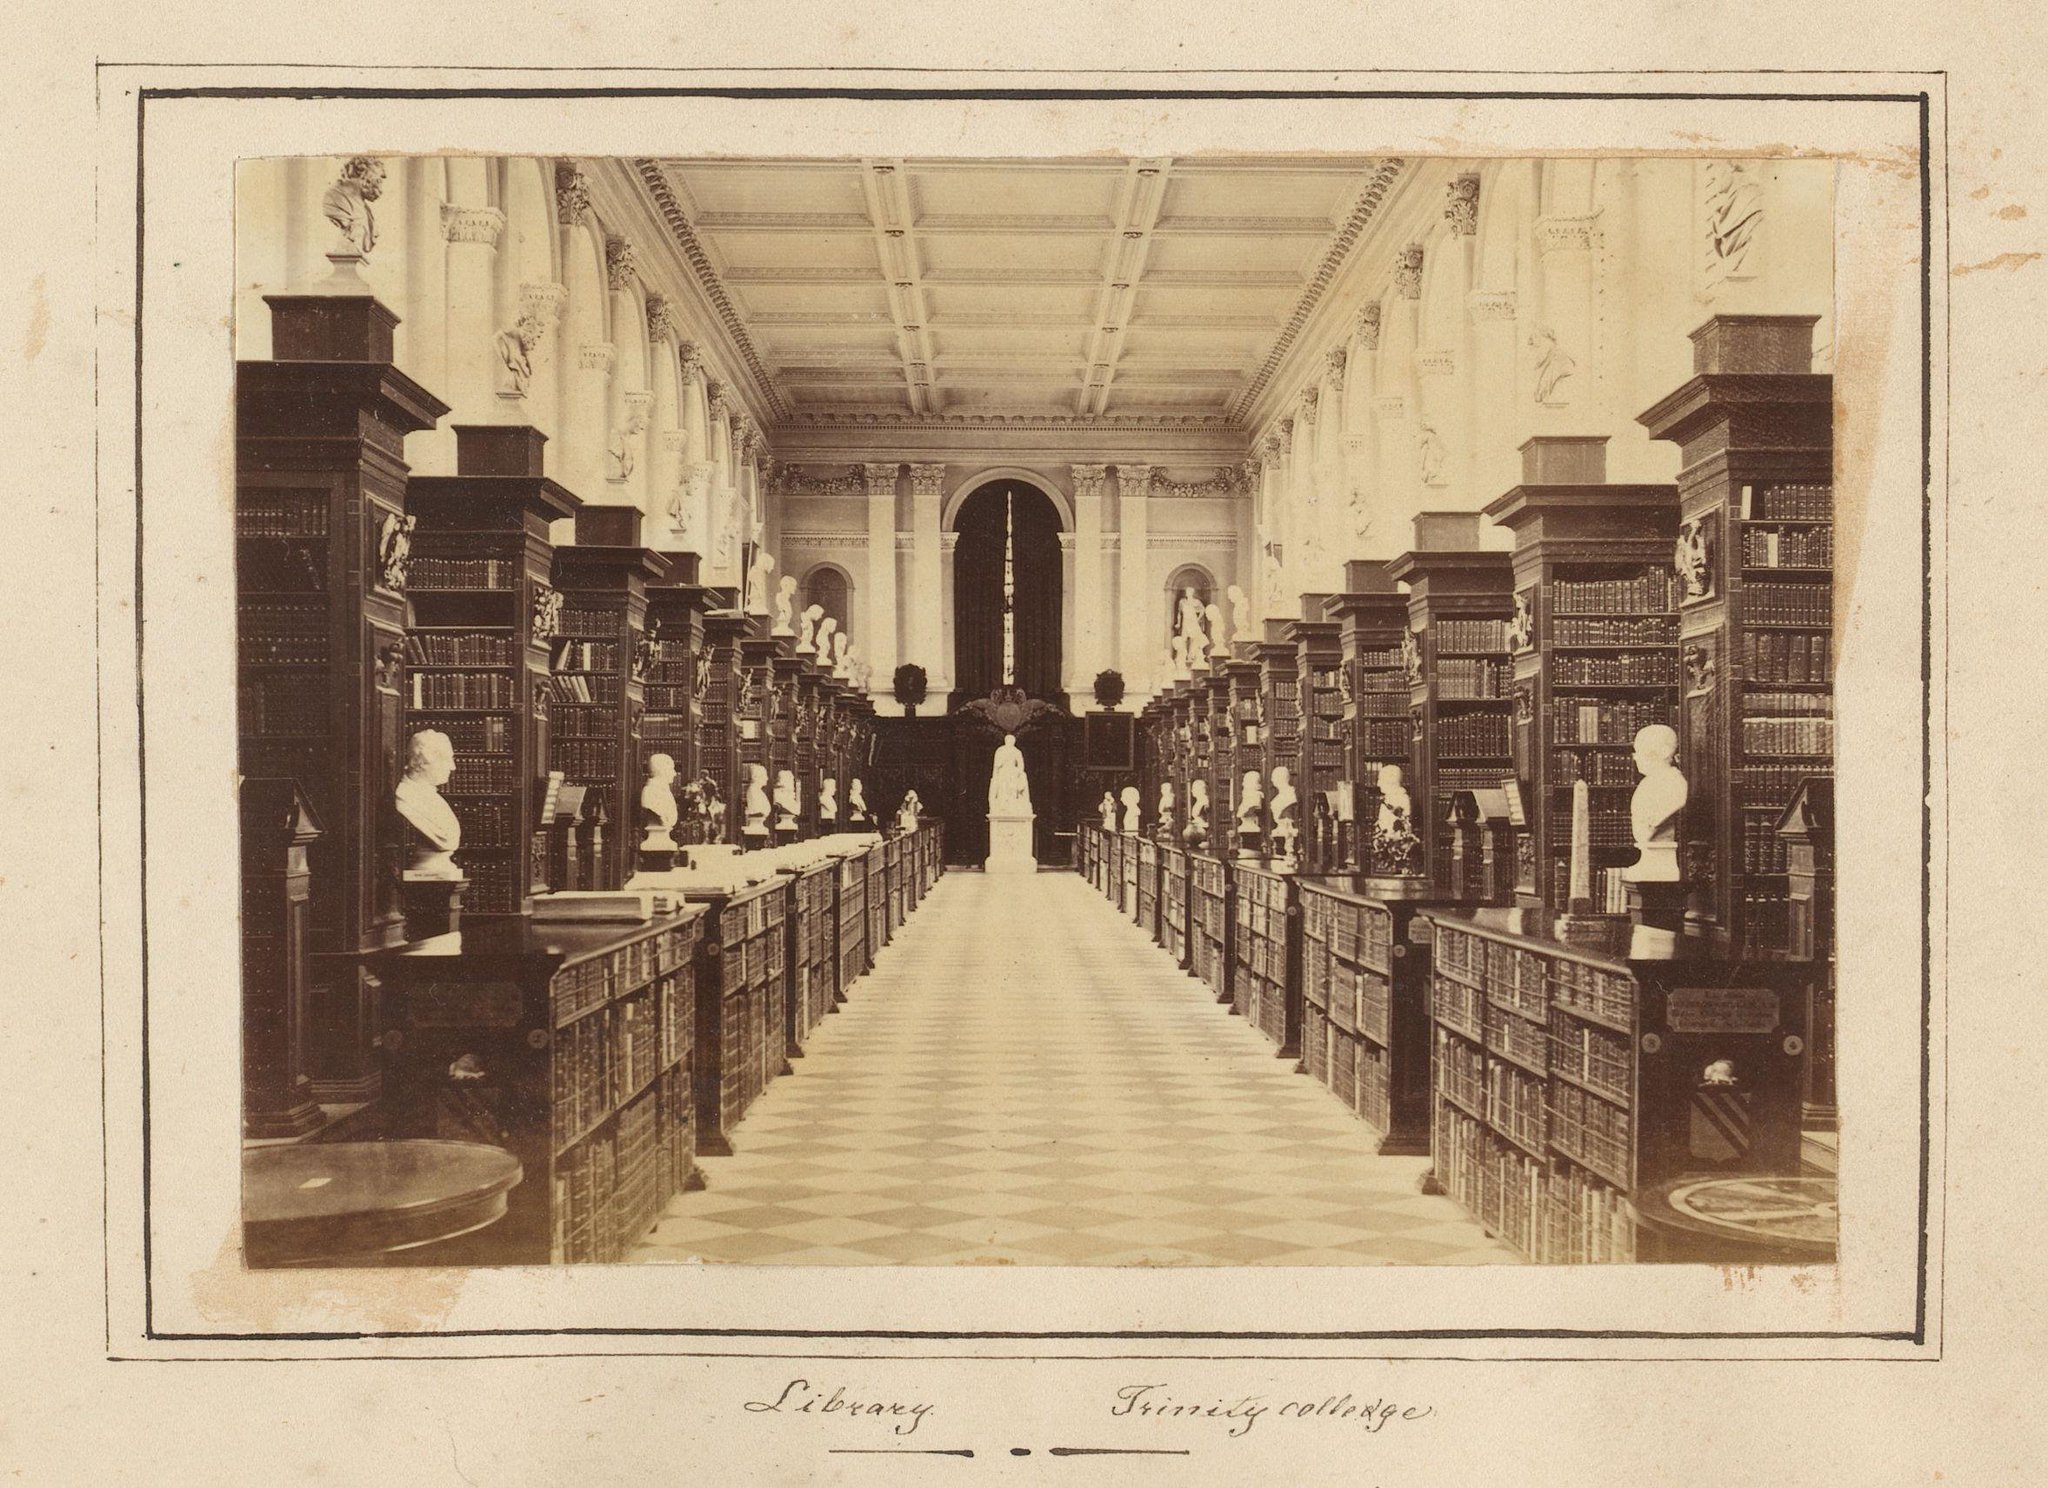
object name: photograph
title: Interieur van de bibliotheek van Trinity College, Cambridge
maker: Anonymous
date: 1865-1890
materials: paper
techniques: albumen print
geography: cambridge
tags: university building, college, public library